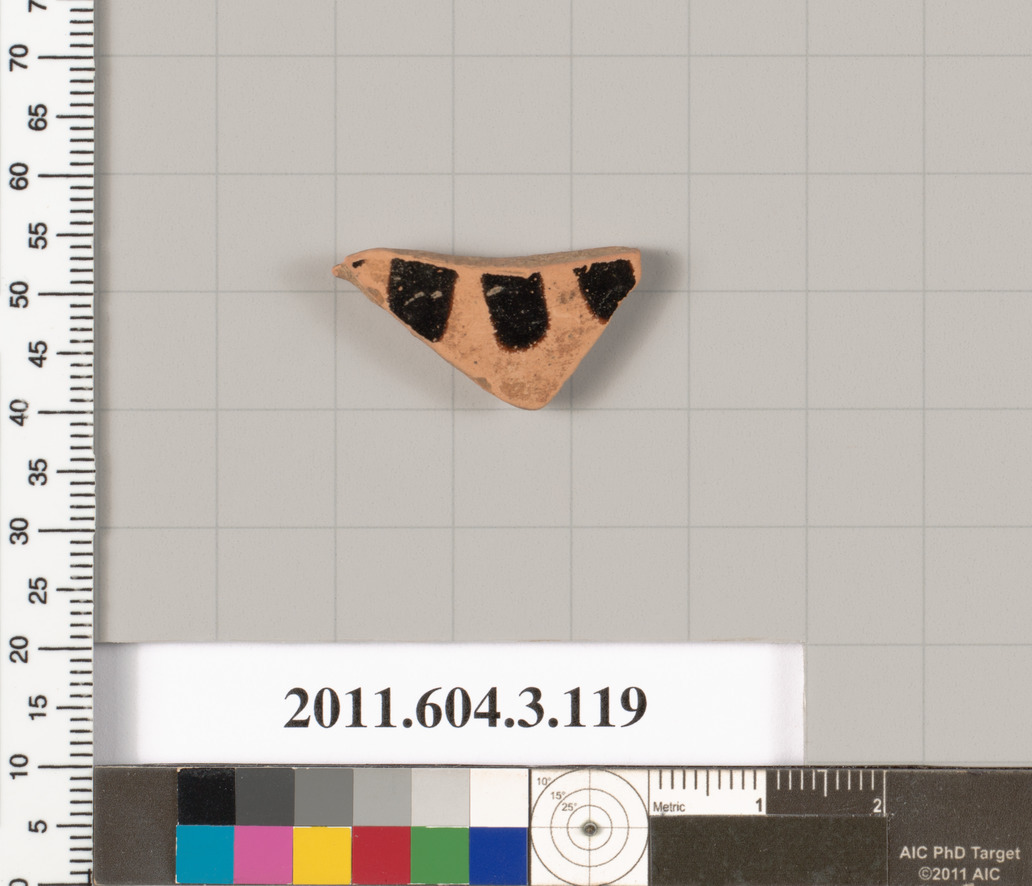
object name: amphora fragment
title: Terracotta fragment of an amphora (jar)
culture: greek, attic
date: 510-500 BCE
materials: terracotta